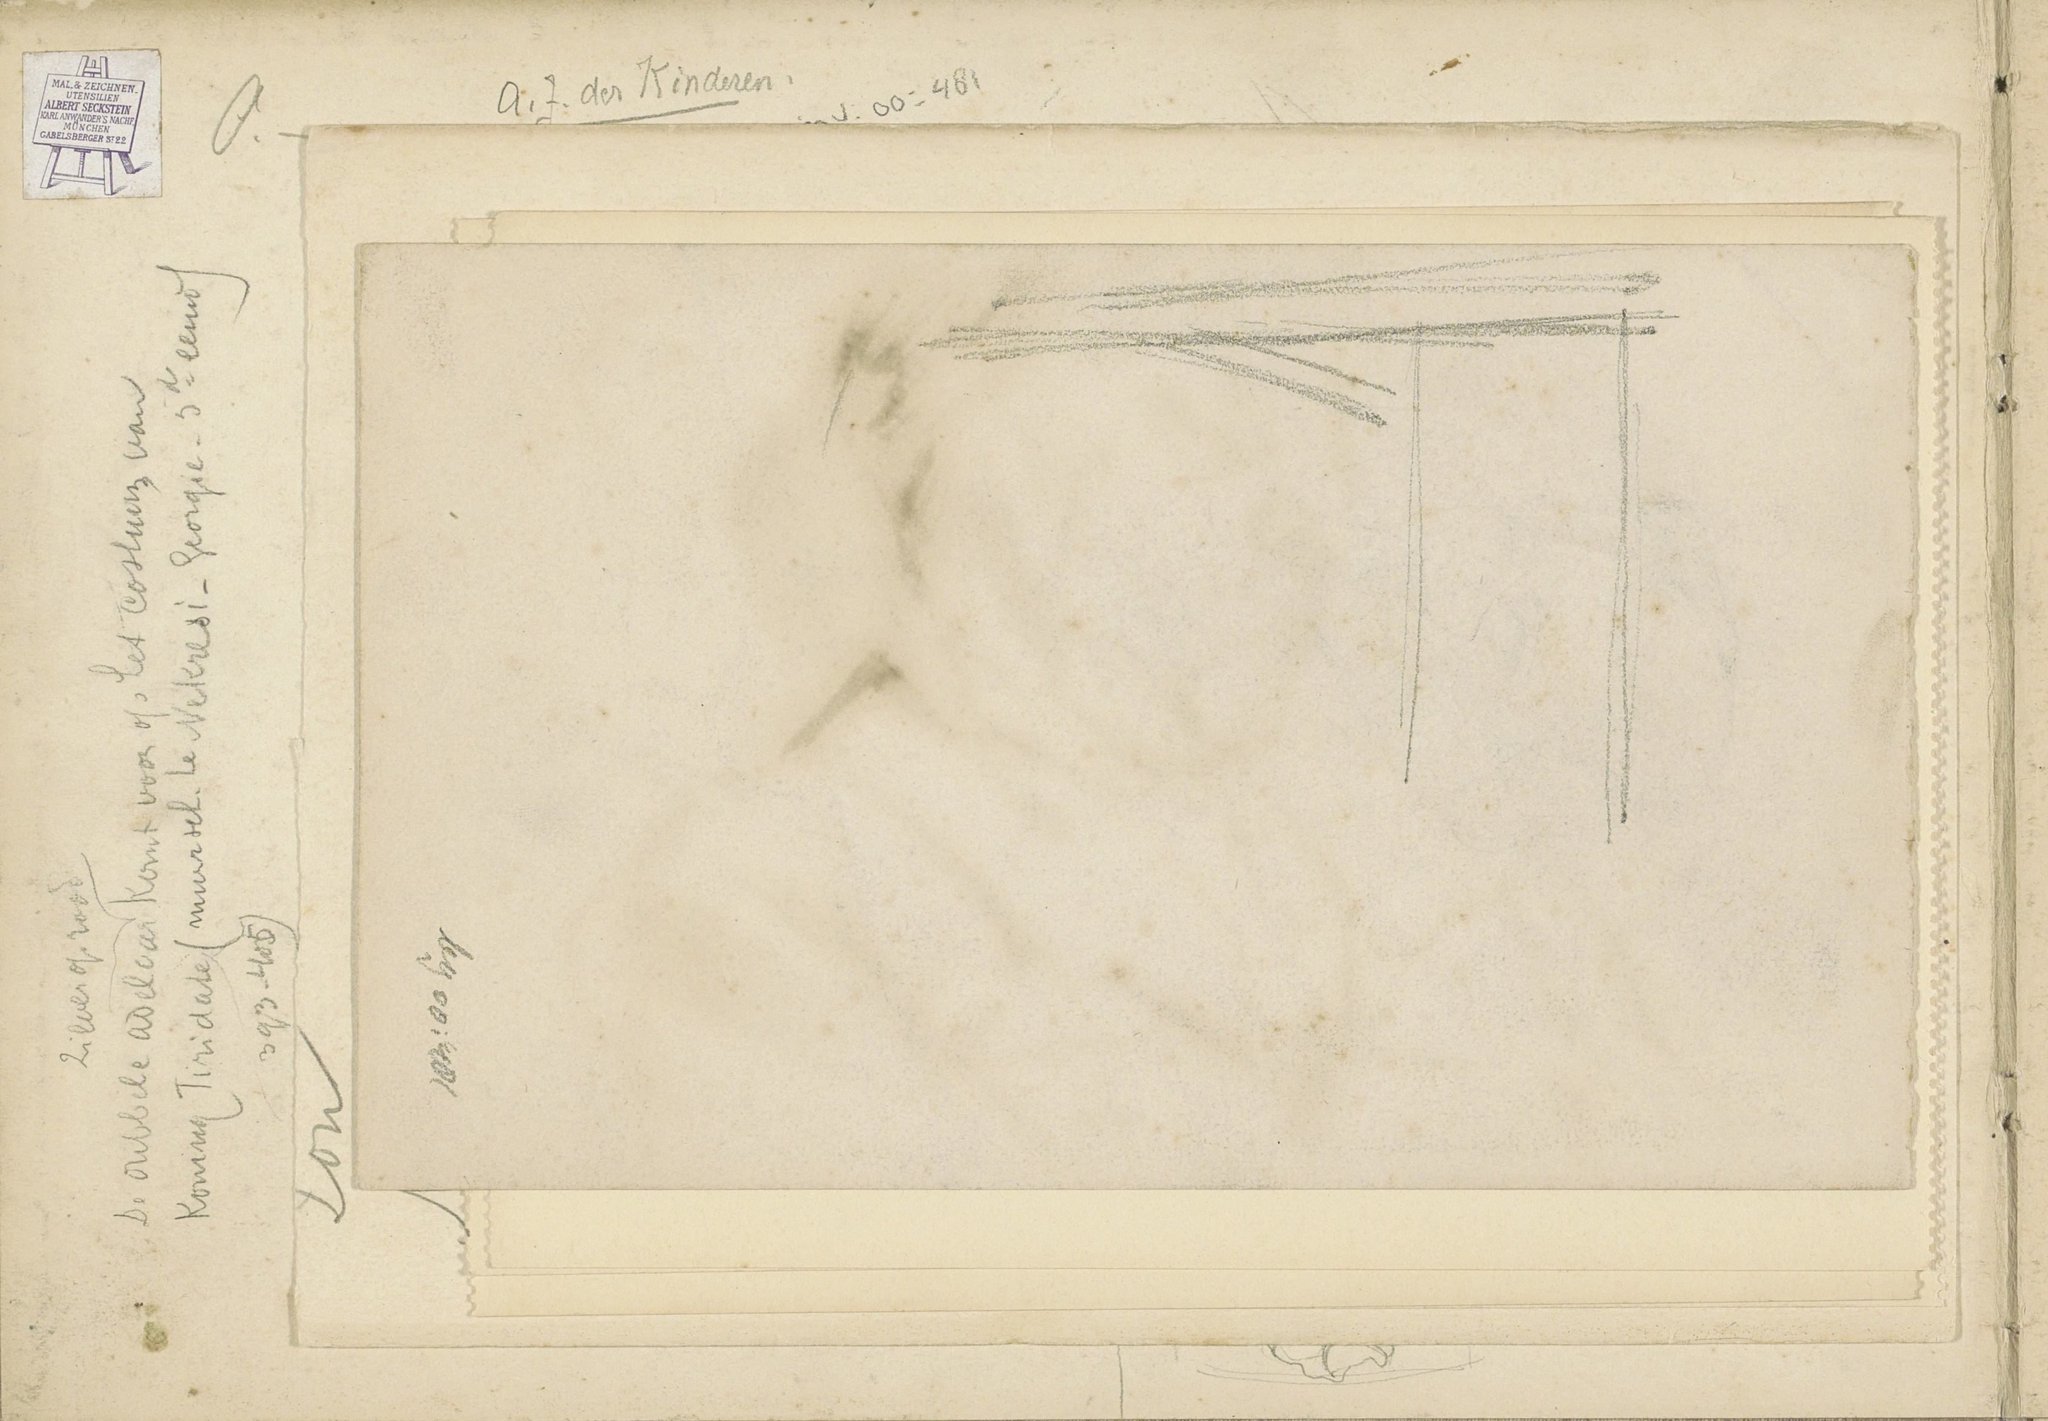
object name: sketchbook leaf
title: Studie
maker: antoon derkinderen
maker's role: draughtsman, painter, print maker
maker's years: 1859-1925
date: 1869-1925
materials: paper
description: Verso van een losse tekening tussen het voorste schutblad en blad 1 uit een schetsboek met 28 bladen.